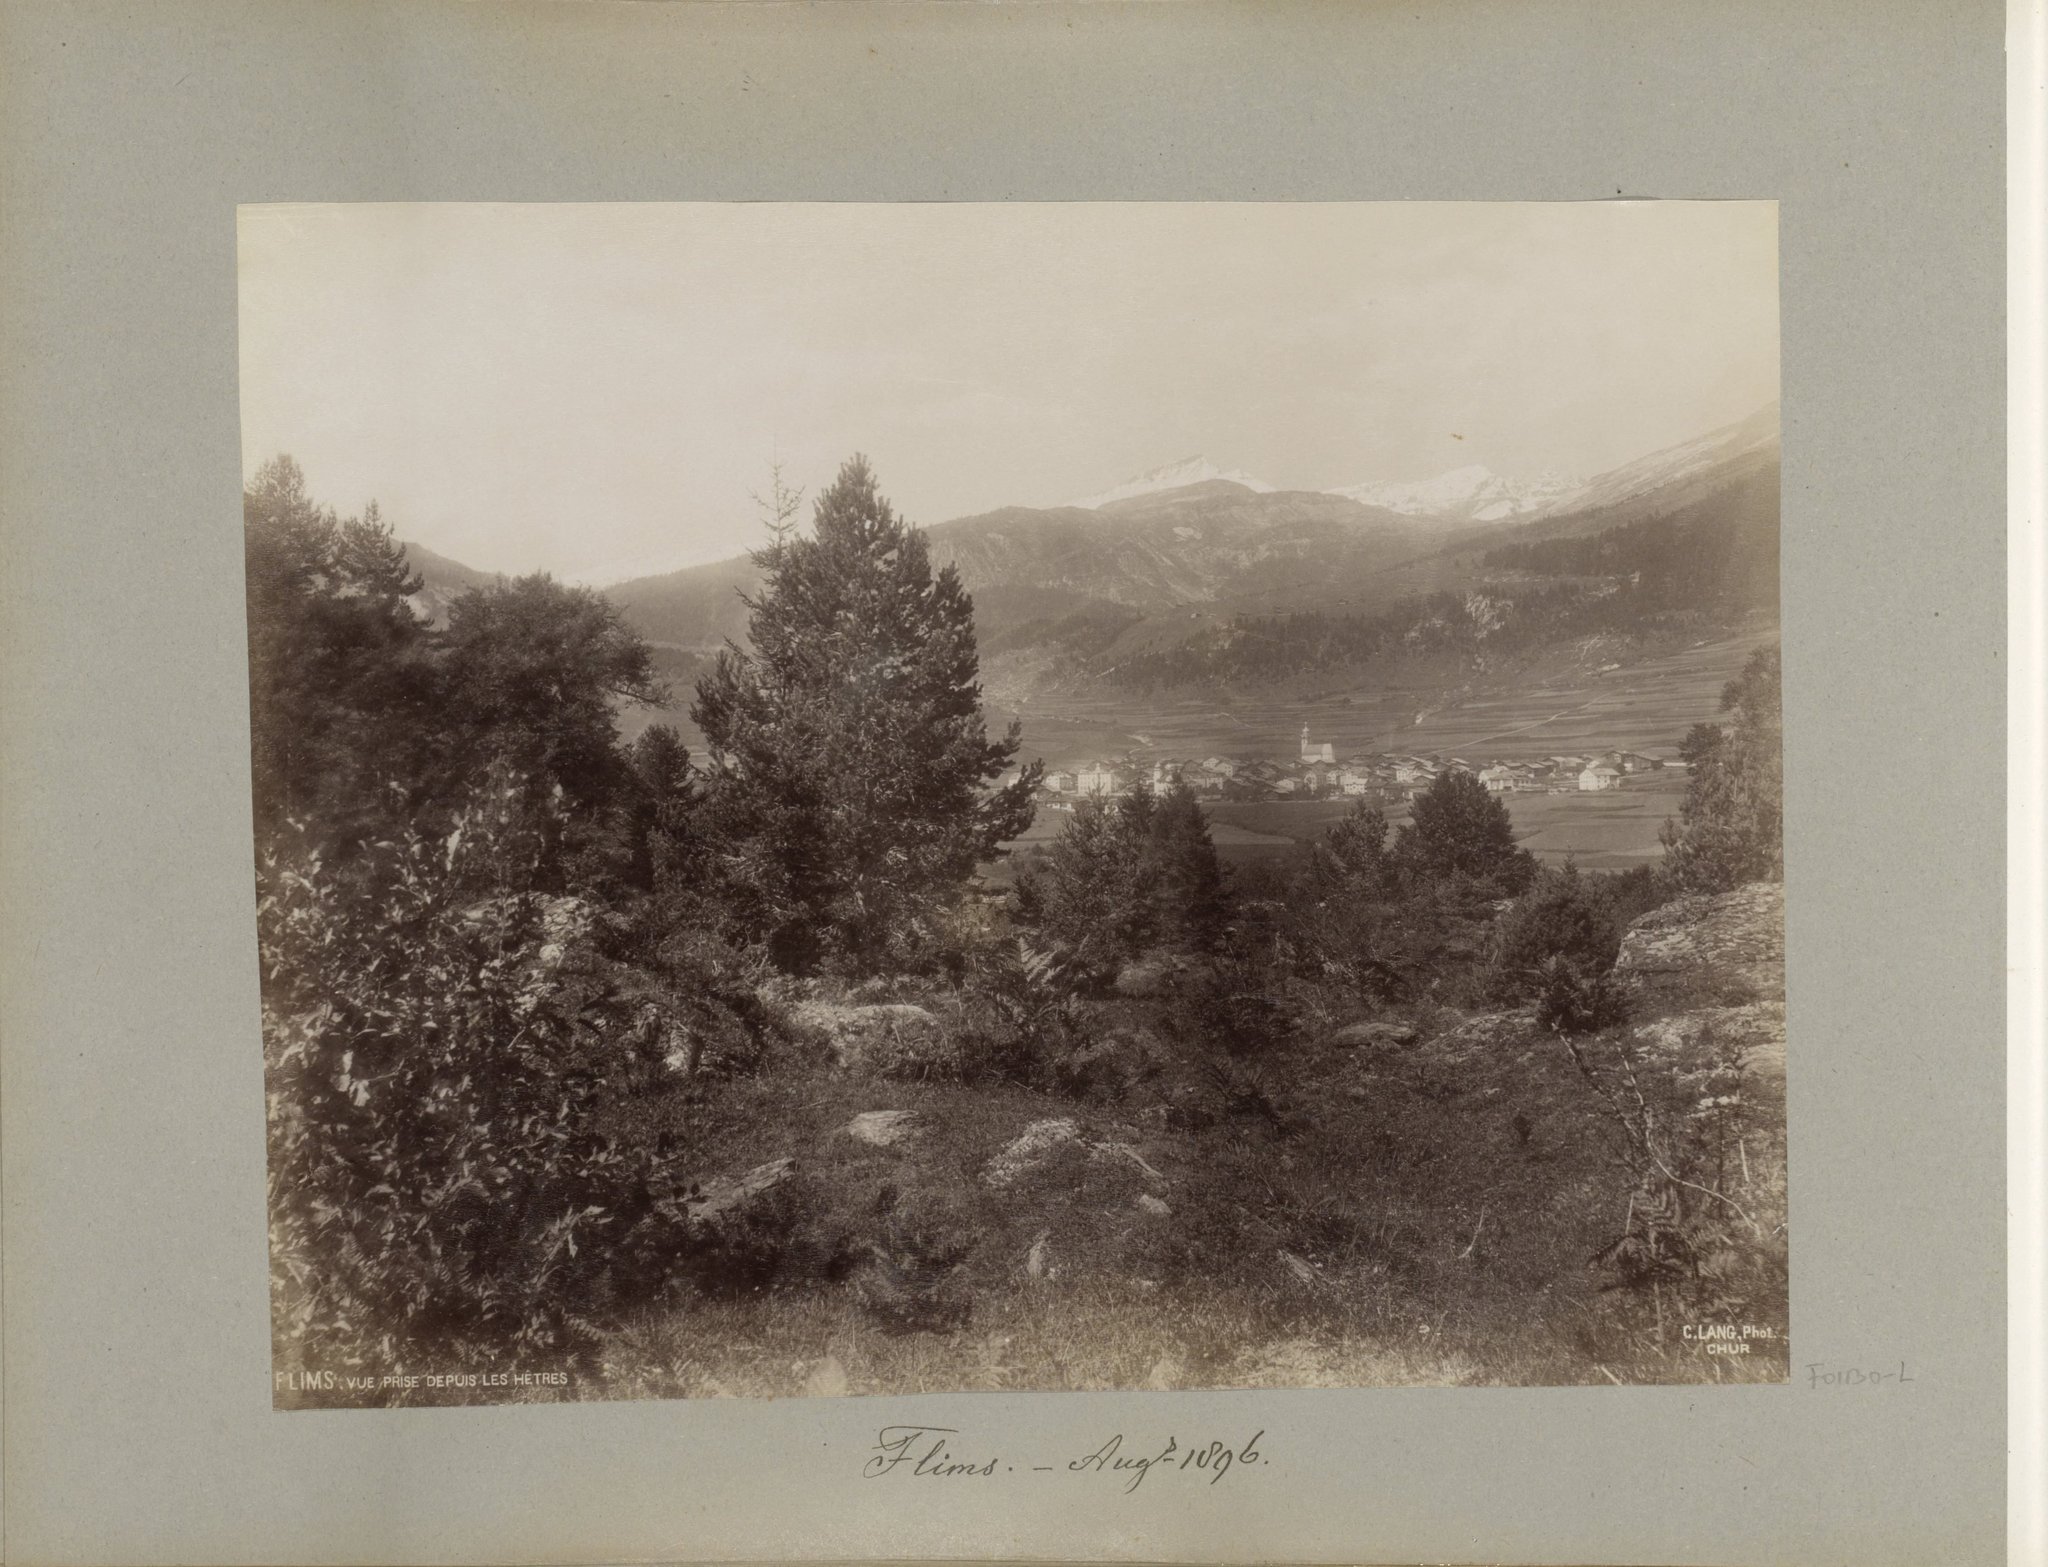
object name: album leaf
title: FLIMS. vue prise depuis les Hêtres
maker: carl lang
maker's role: fotograaf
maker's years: 1830-1906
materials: paper, photographic support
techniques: albumen print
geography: flims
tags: prospect of village, silhouette of village, dale, valley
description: Onderdeel van Reisalbum met foto's van bezienswaardigheden in Frankrijk, Spanje, Italië, Duitsland, Zwitserland en Oostenrijk.